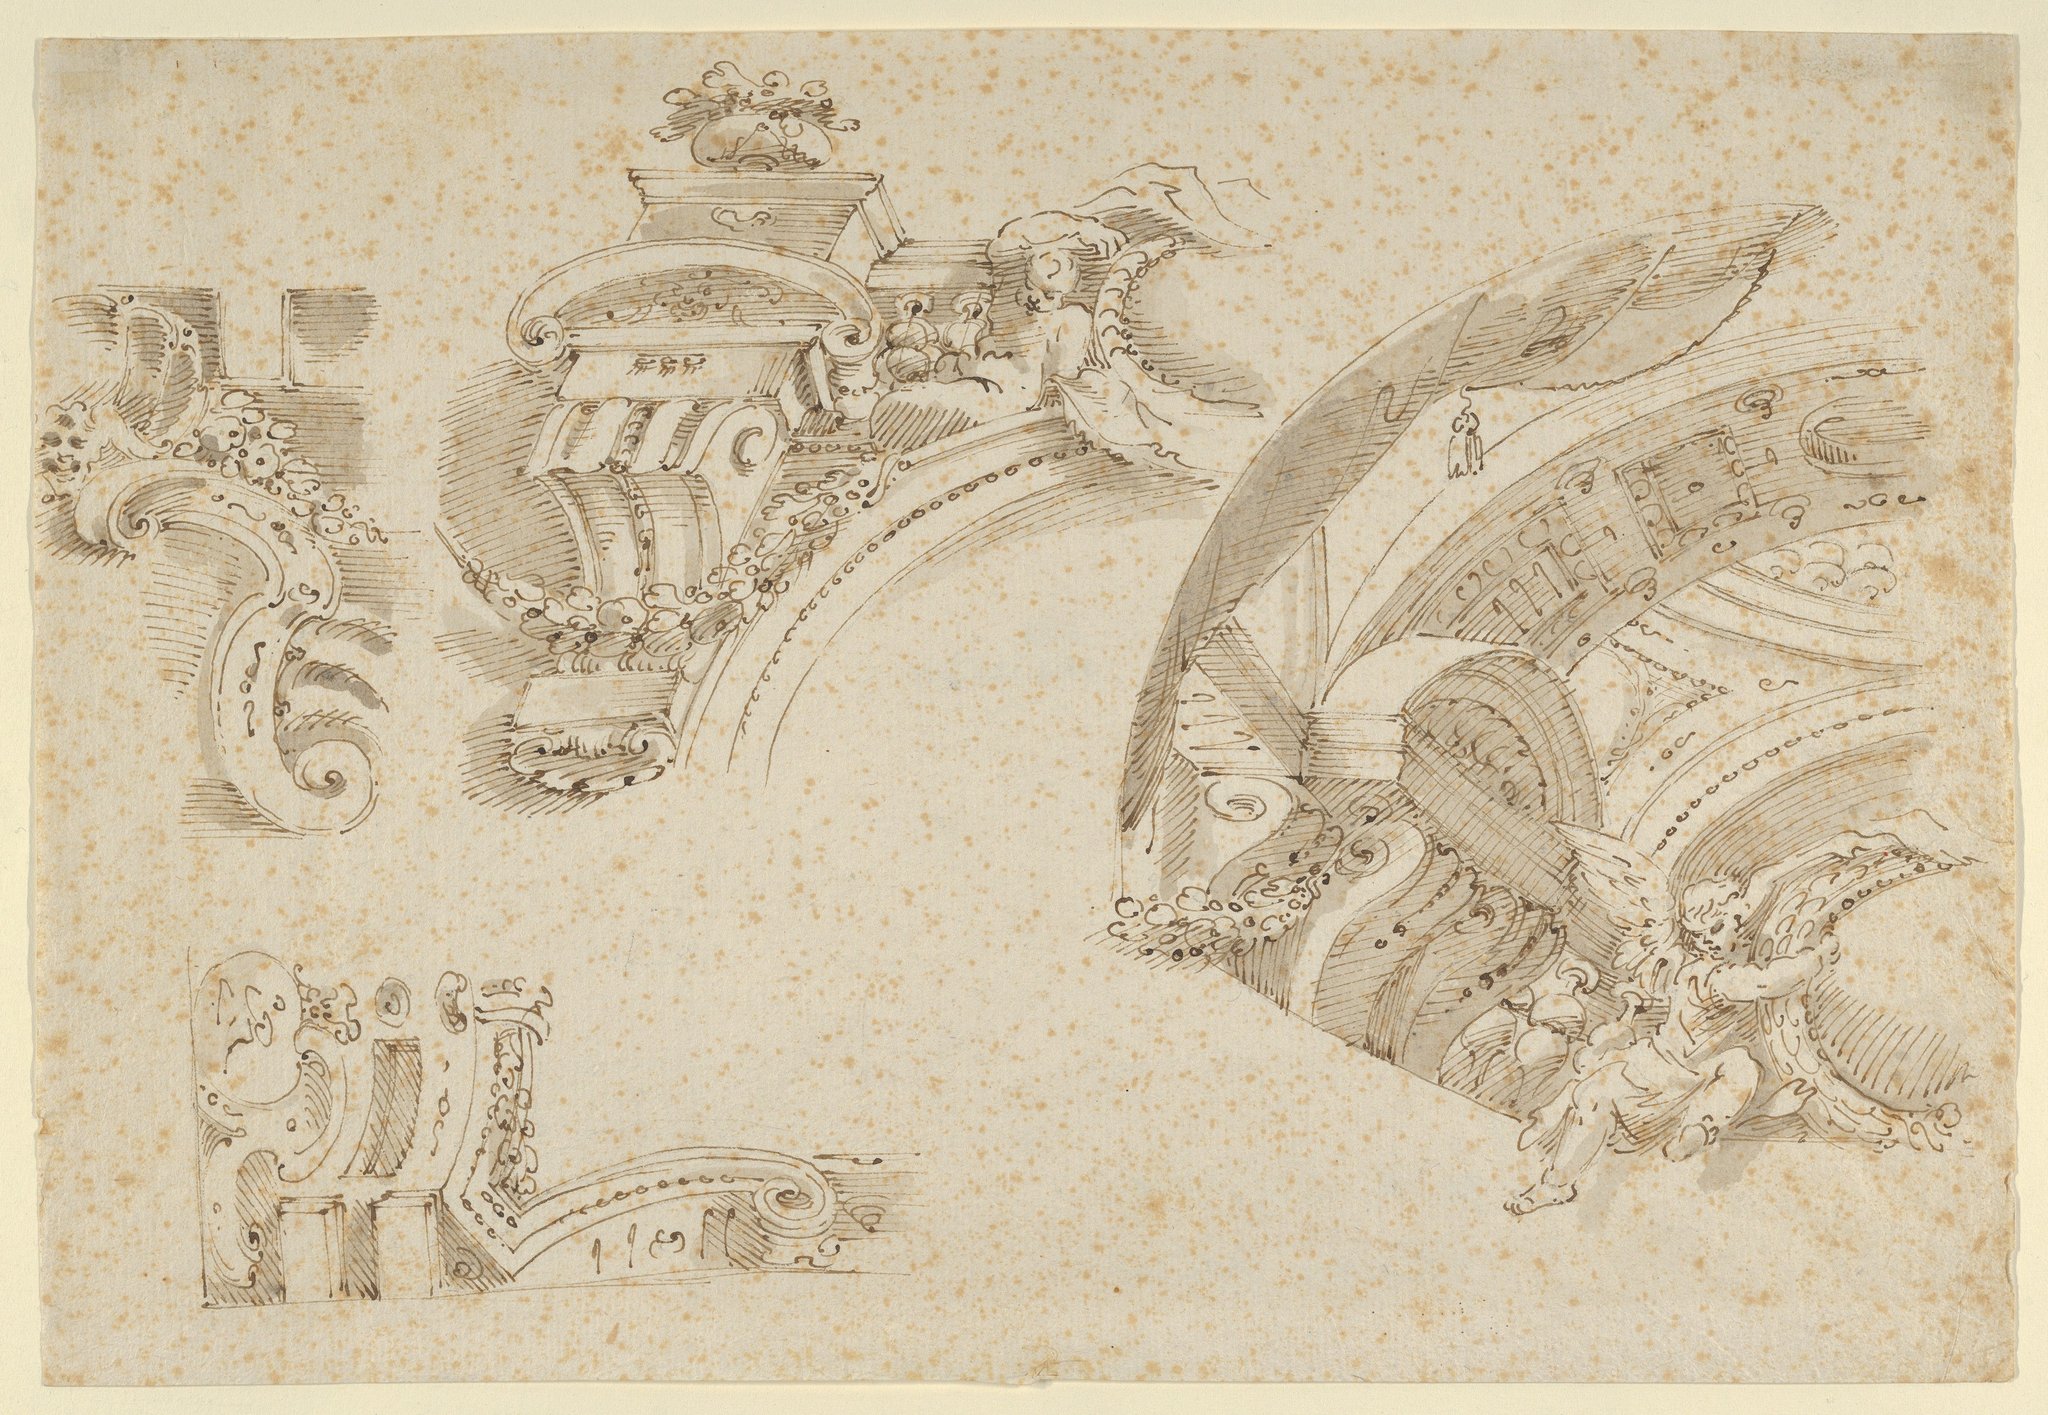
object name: drawing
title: Architecture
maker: michelangelo colonna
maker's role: artist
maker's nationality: italian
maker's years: 1604-1687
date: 1601-1700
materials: ink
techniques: pen, wash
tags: architecture